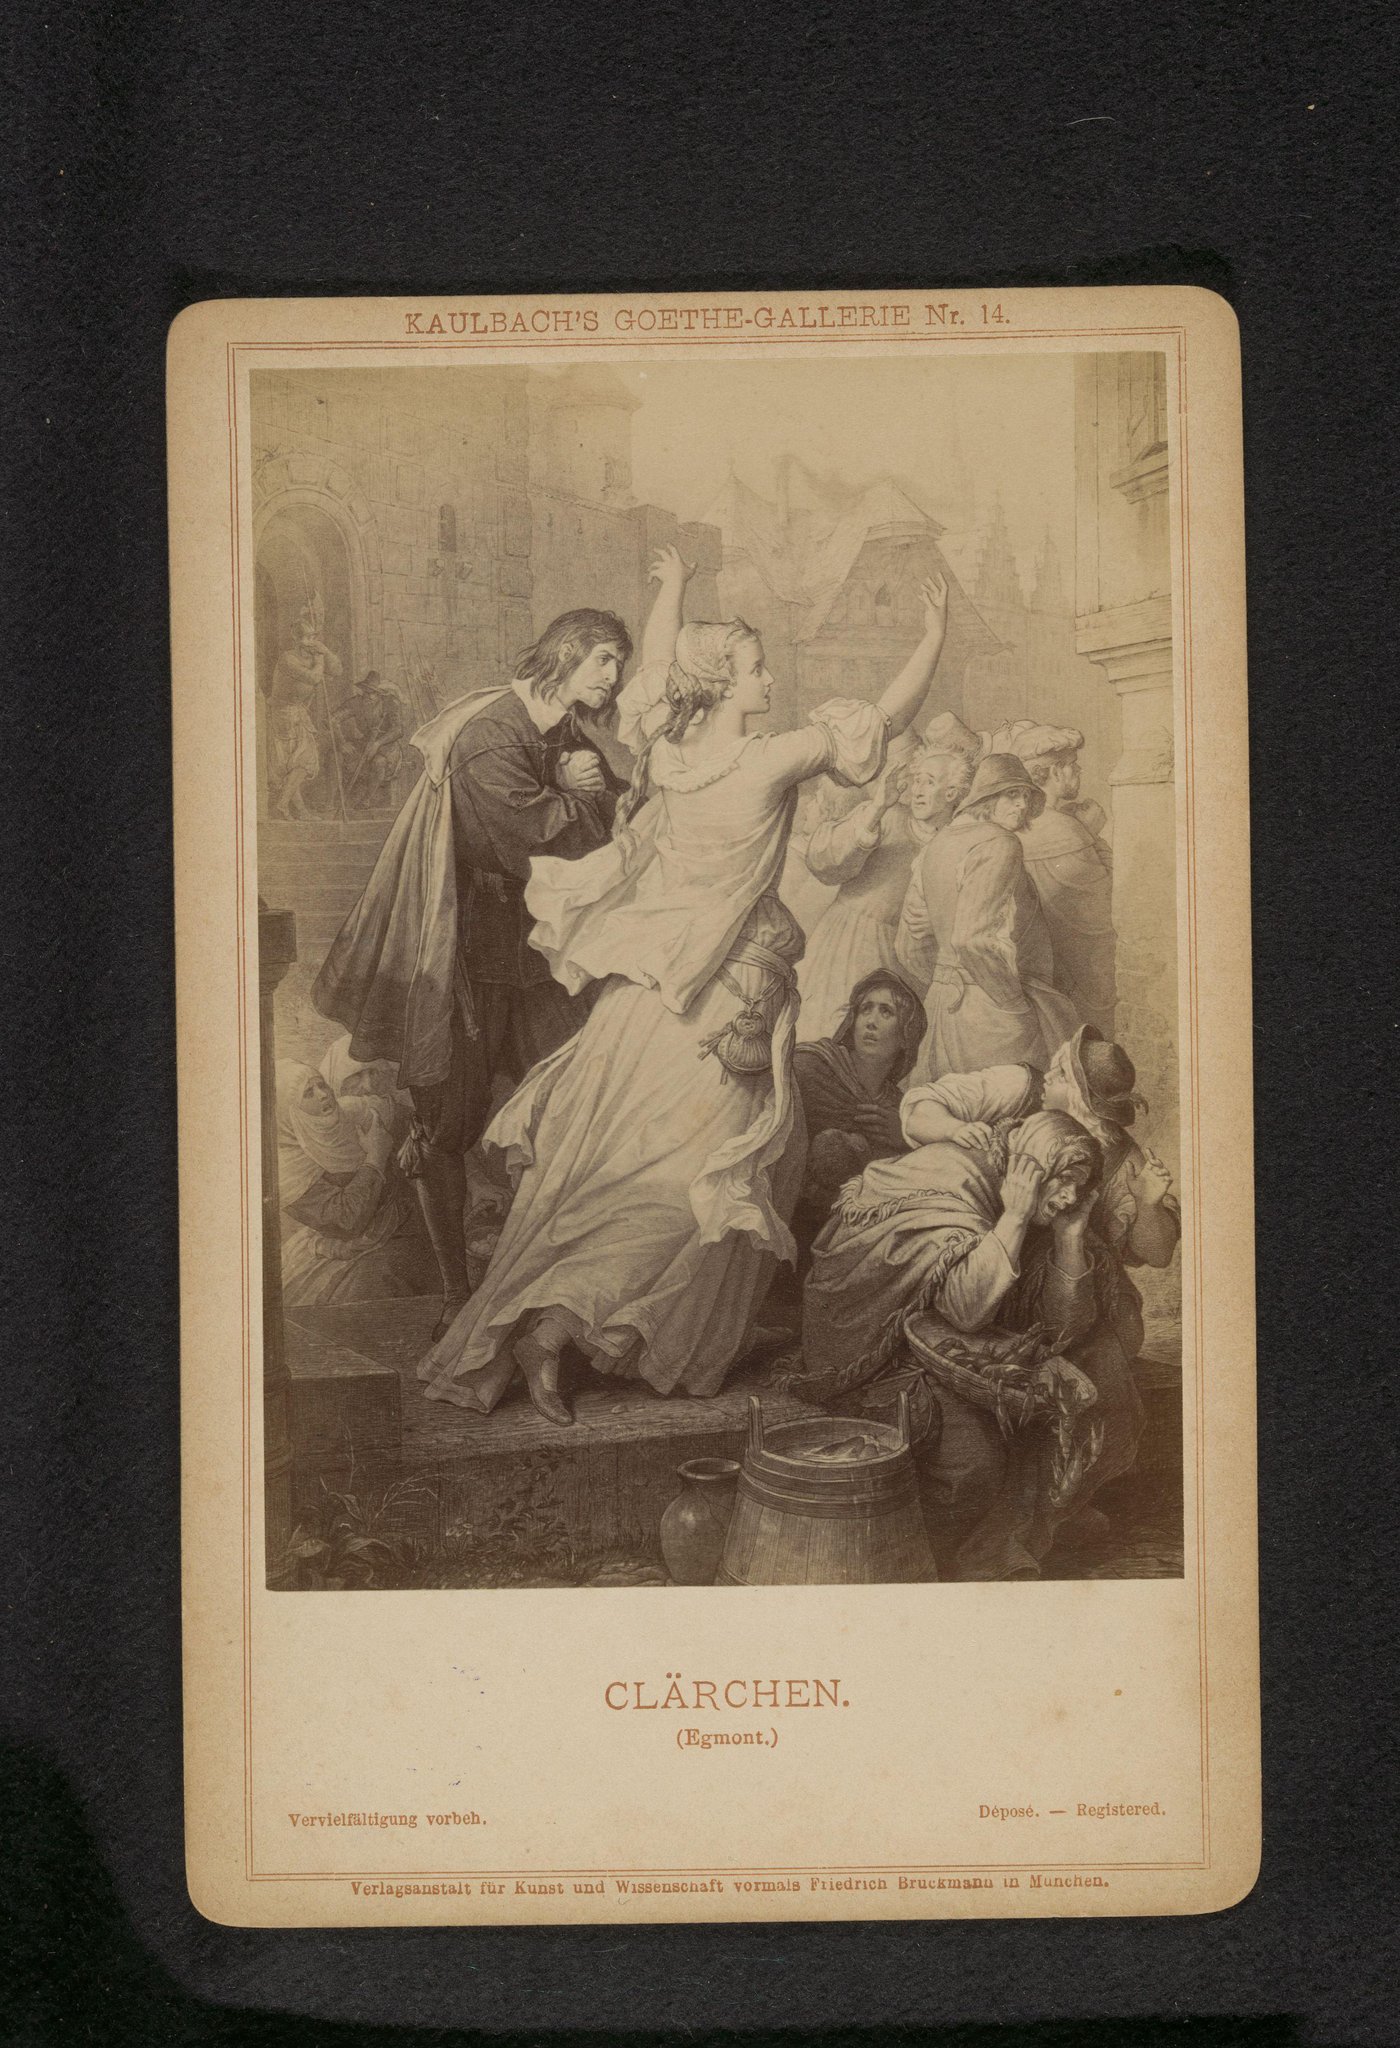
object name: photograph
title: Fotoreproductie van een scène uit Goethe's Egmont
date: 1880-1885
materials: photographic support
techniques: albumen print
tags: literary characters and objects, painting, drawing and the graphic arts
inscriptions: annotation: ‘24.12.94’, name: ‘Friedrich Bruckmann's Verlag/ München’, inscription: ‘Vervielfältigung vorbeh. Déposé - Registered./ Verlagsanstalt für Kunst und Wissenschaft vormals Friedrich Bruckmann in München.’, inscription: ‘Kaulbach's Goethe-Gallerie Nr. 14’